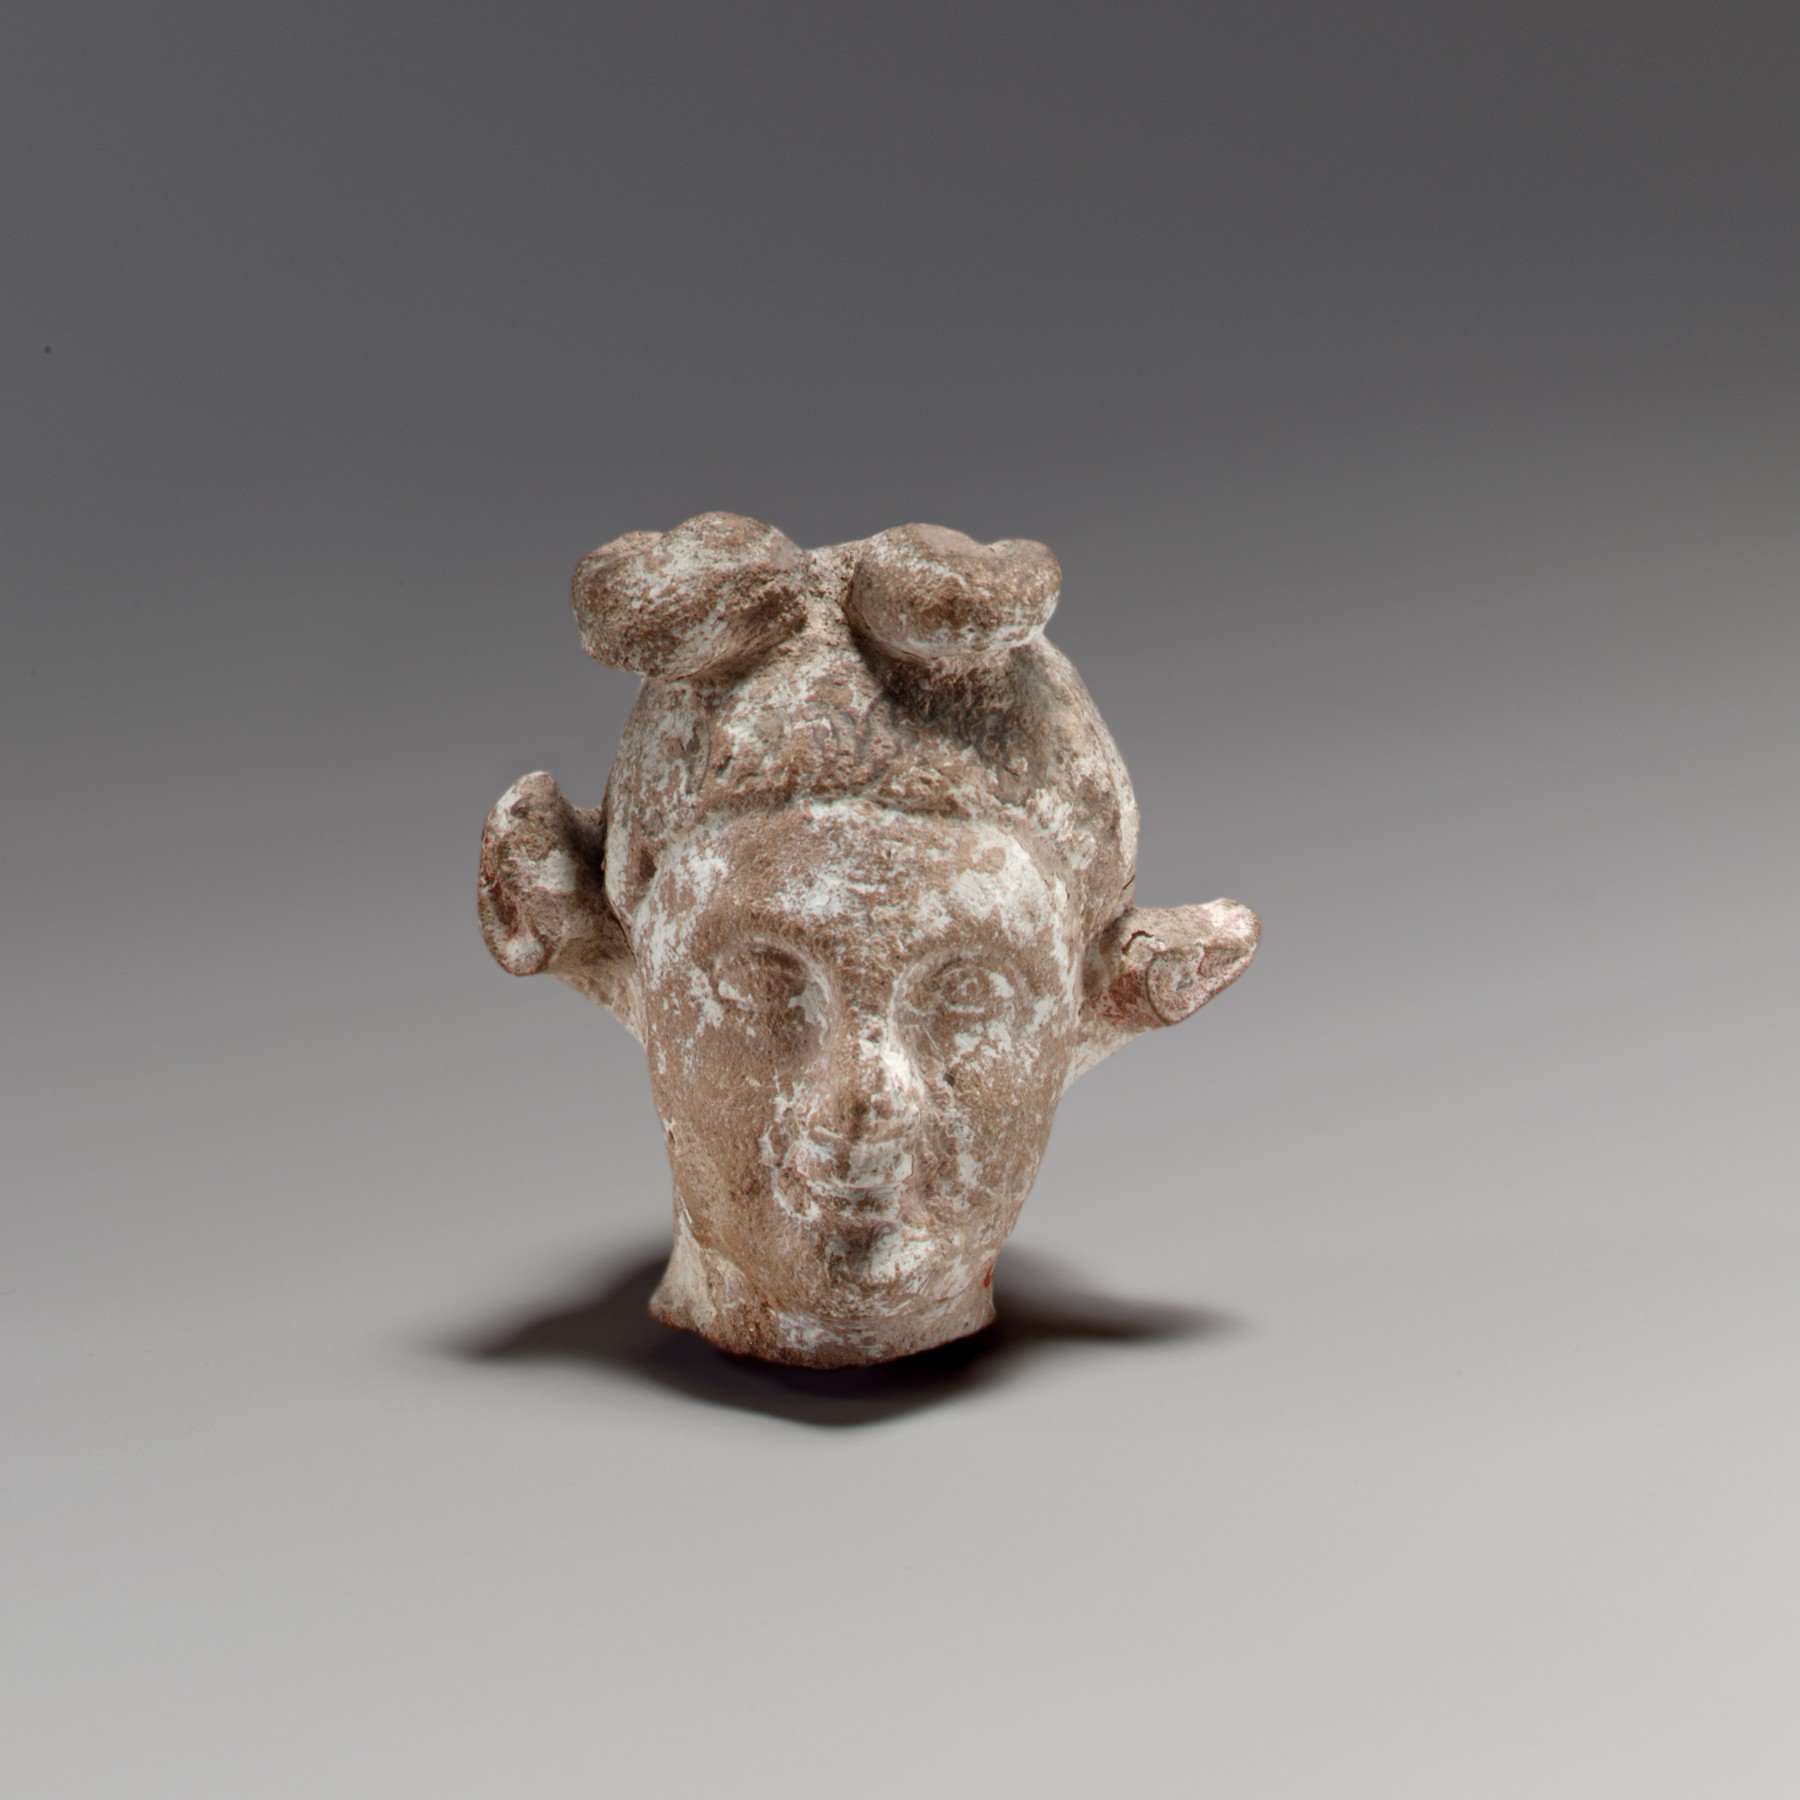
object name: head of a deity with horn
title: Terracotta head of a youth with a goat headdress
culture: cypriot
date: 400-201 BCE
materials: terracotta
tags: heads